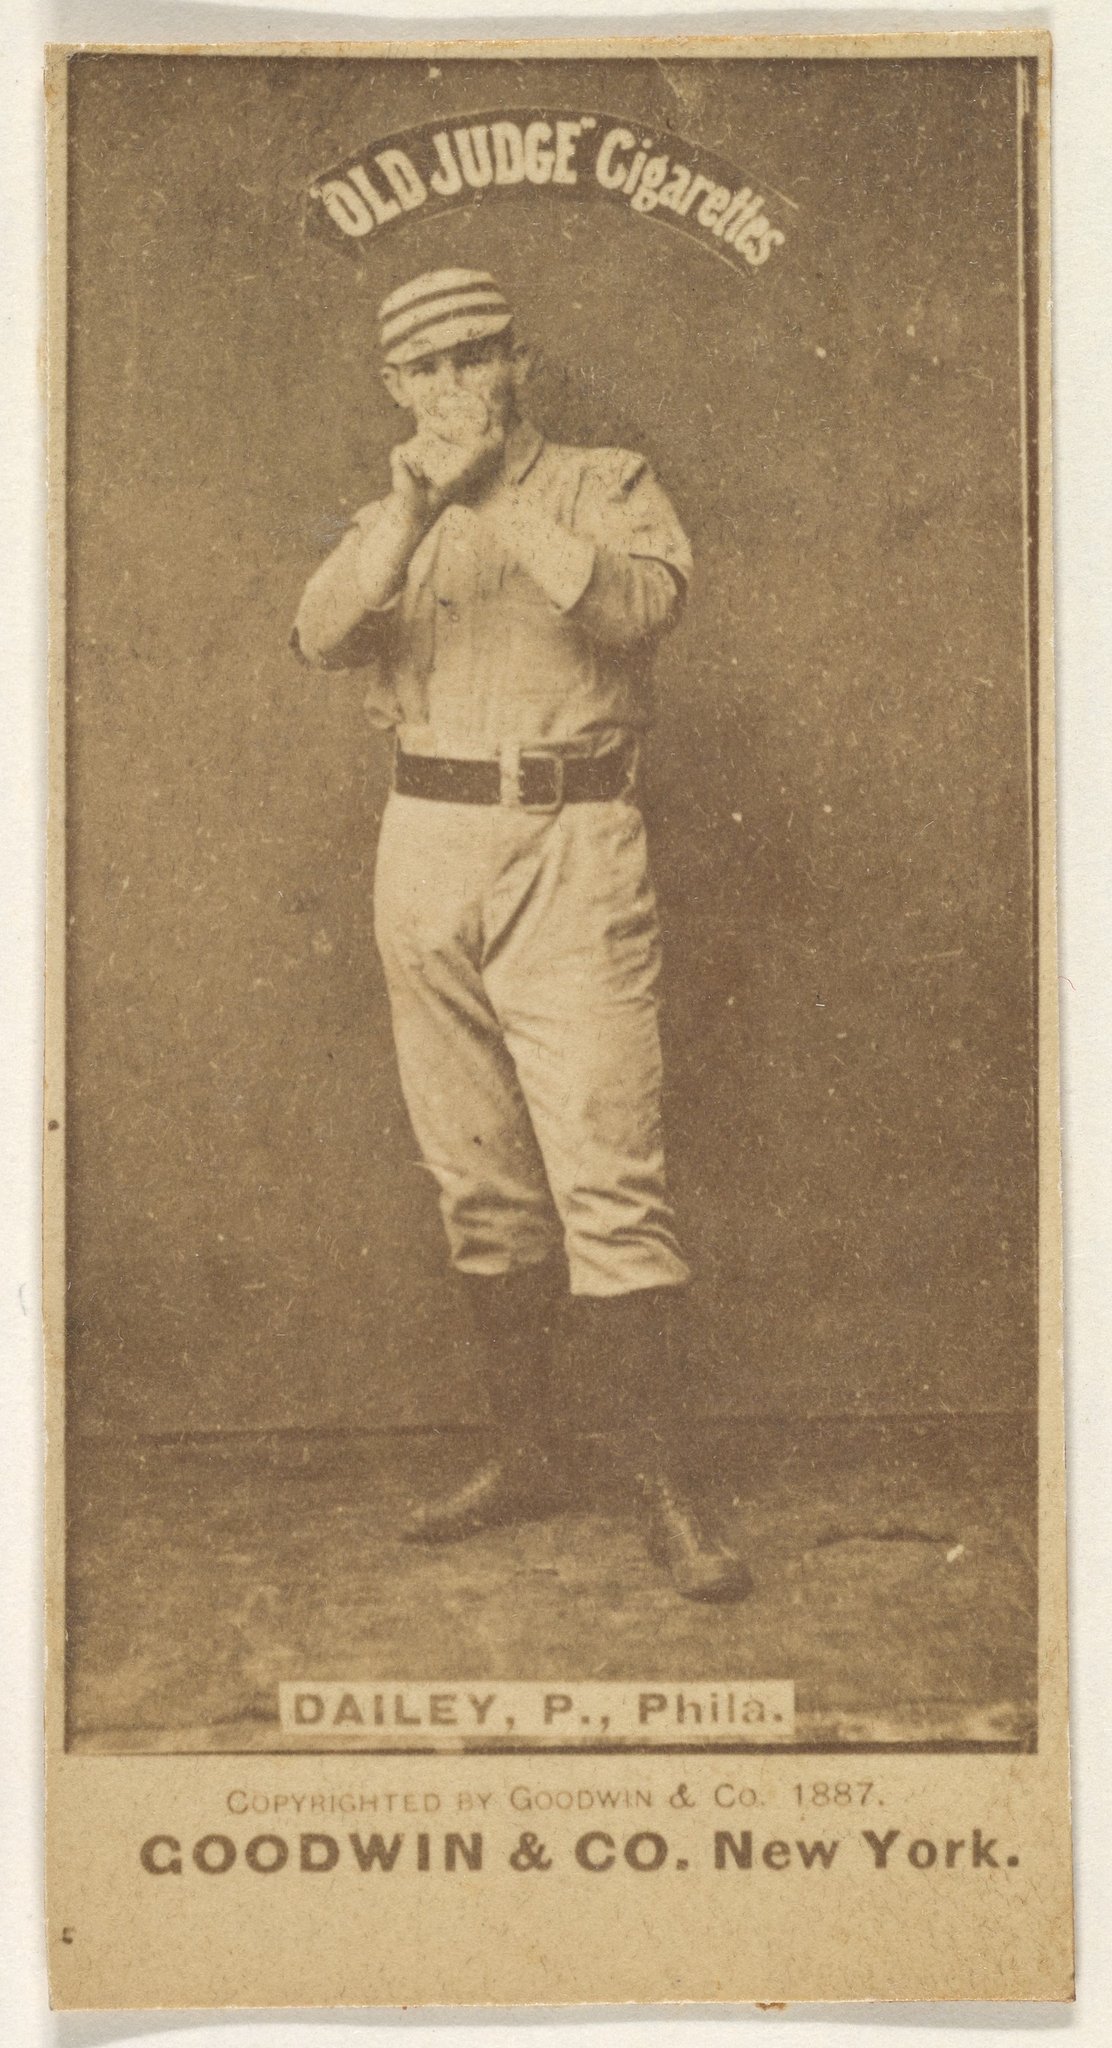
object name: baseball card, photograph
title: Edward M. Daily, Pitcher, Philadelphia, from the Old Judge series (N172) for Old Judge Cigarettes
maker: goodwin & company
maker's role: publisher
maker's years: 1850-1950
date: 1887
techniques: albumen silver print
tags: men,portraits,baseball,athletes